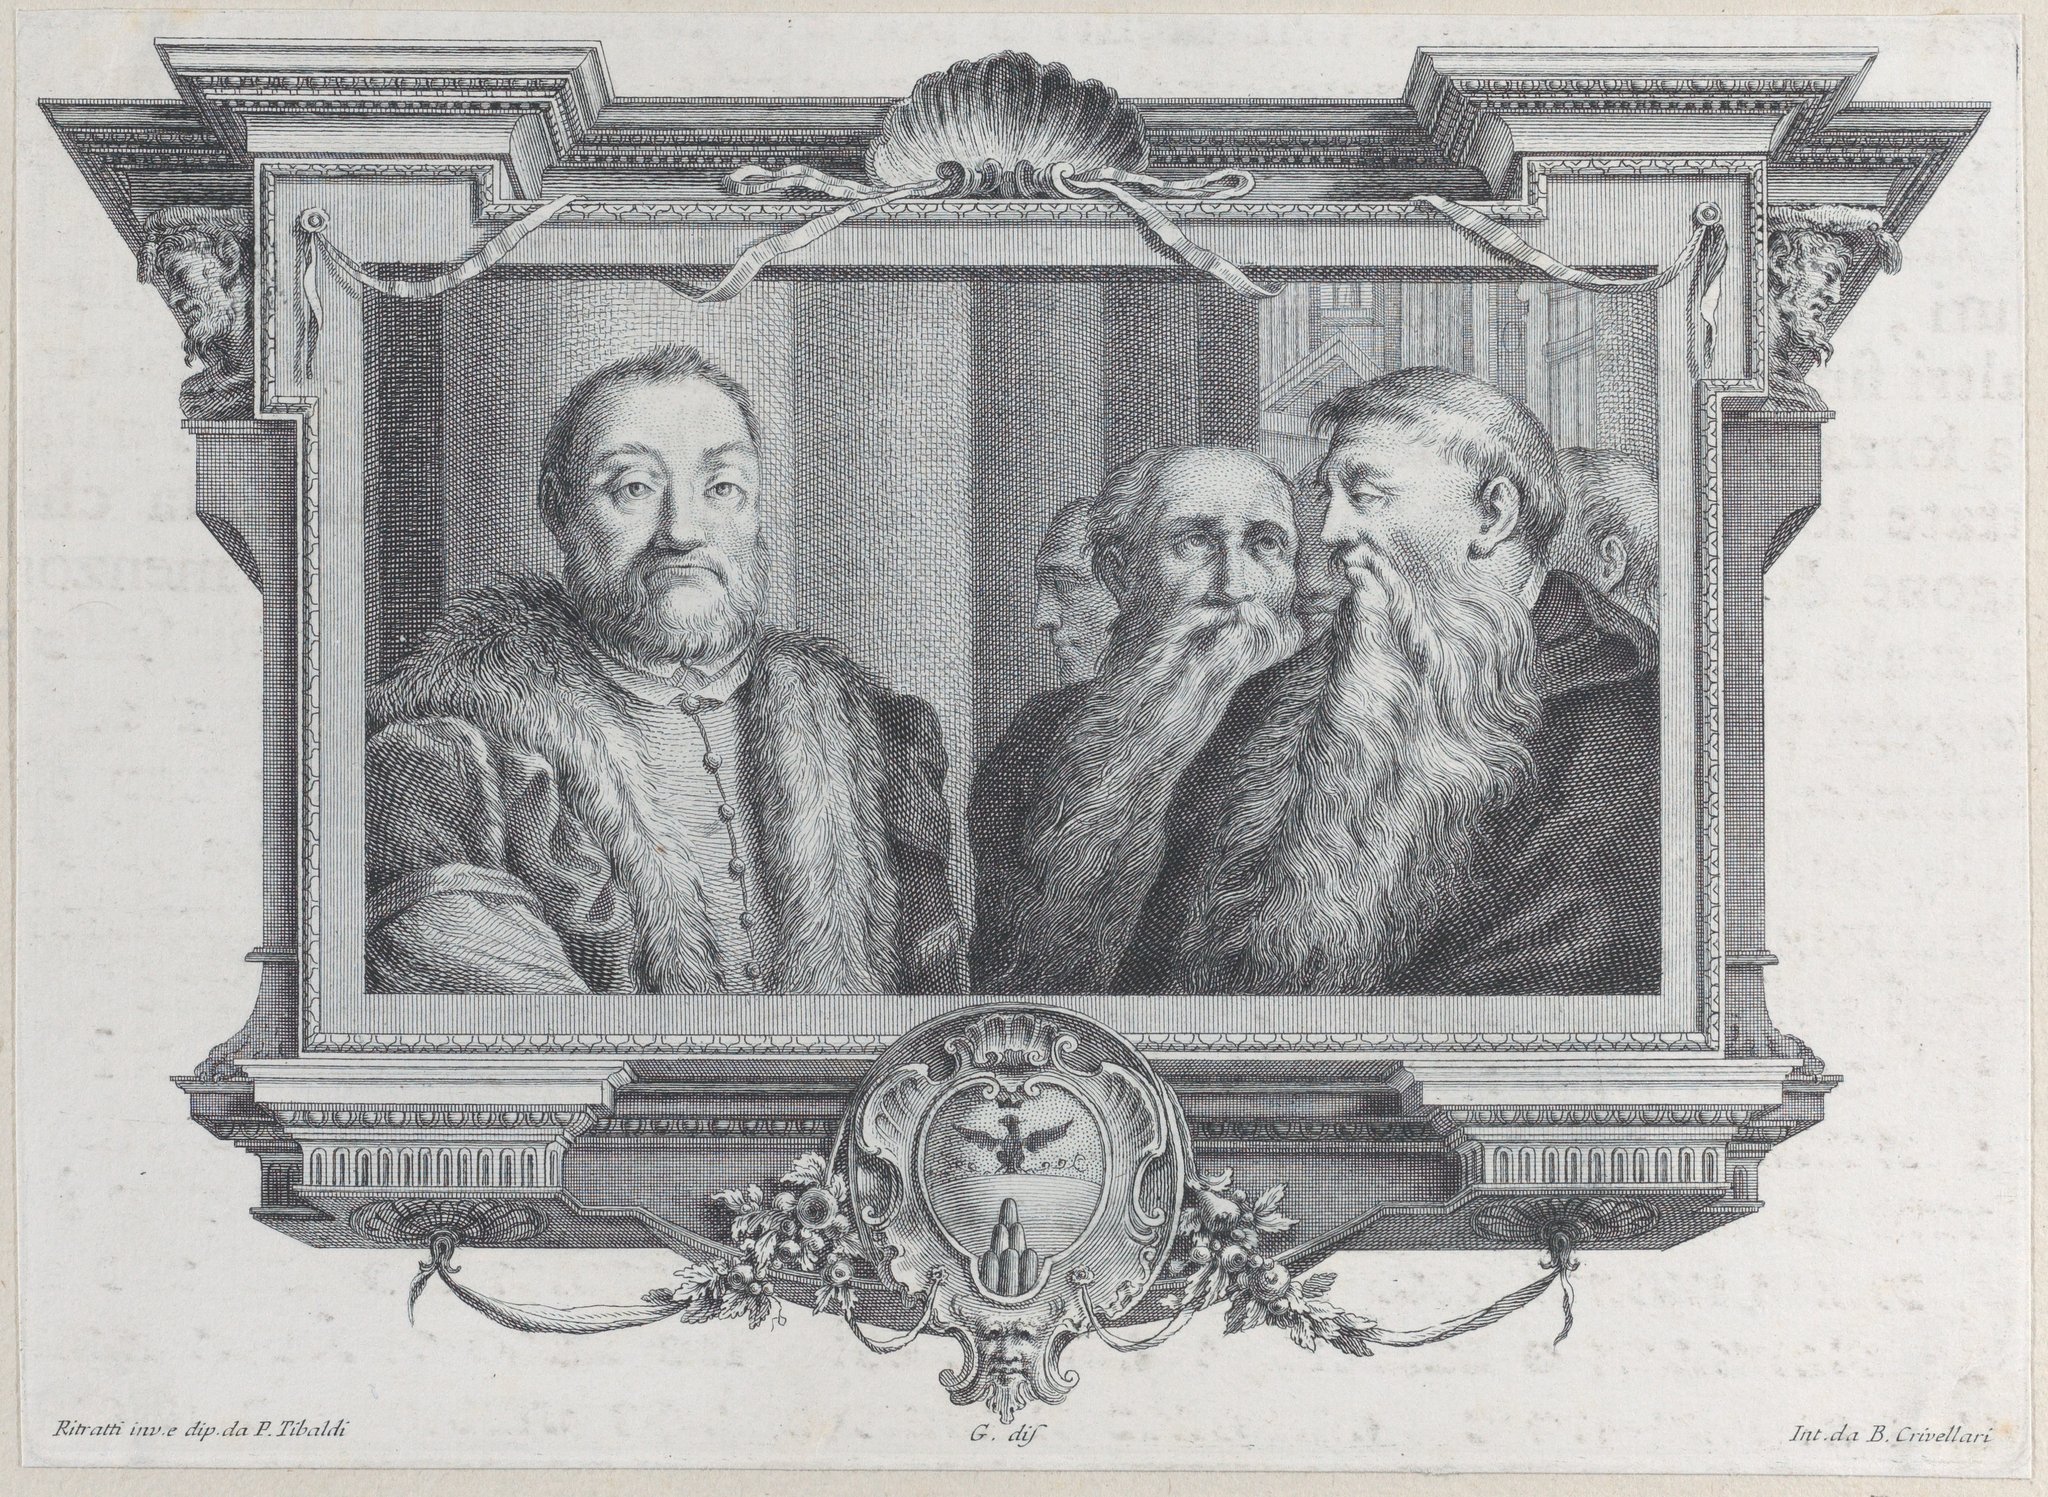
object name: print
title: Three bearded men, one wearing fur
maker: bartolomeo crivellari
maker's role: artist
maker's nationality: italian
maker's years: 1700-1800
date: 1756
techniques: engraving, etching